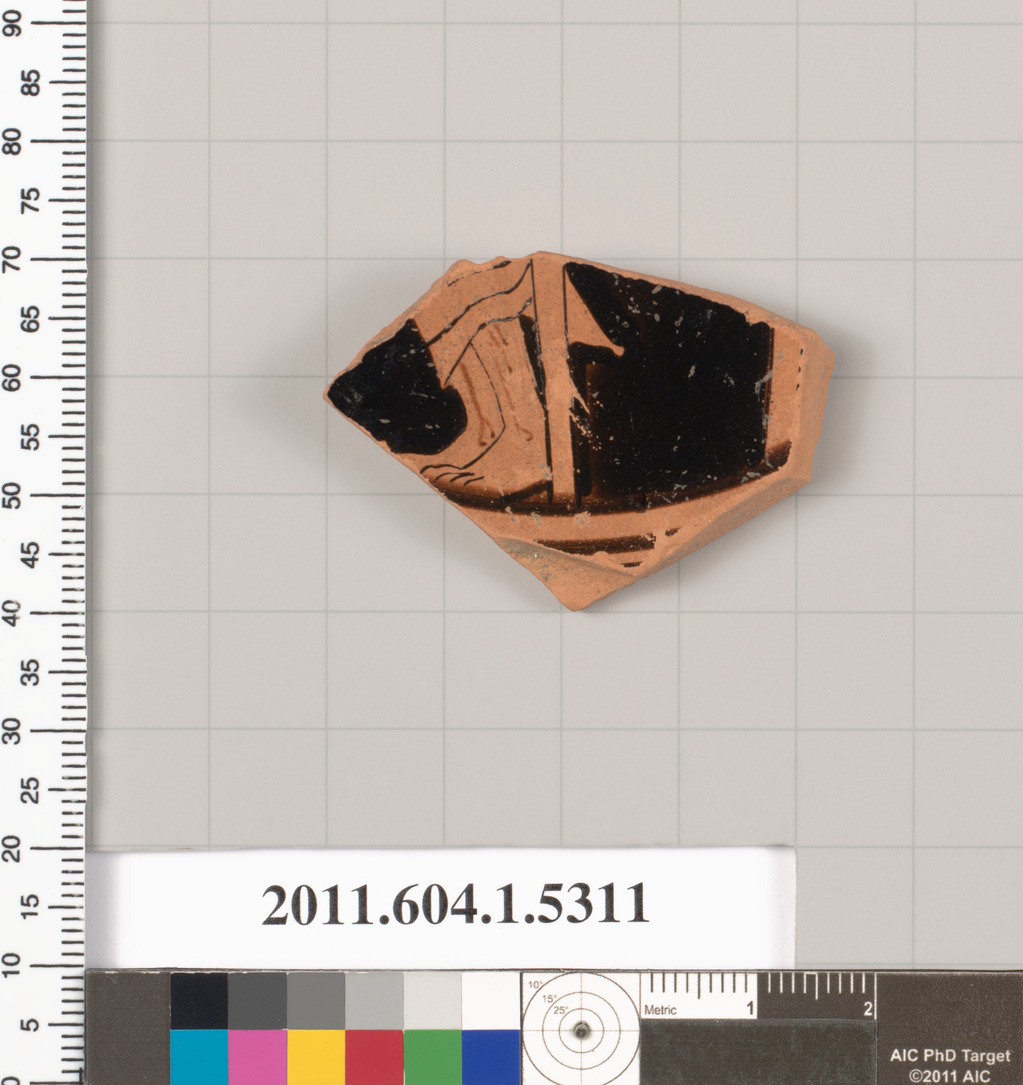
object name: kylix fragment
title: Terracotta fragment of a kylix (drinking cup)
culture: greek, attic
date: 500-470 BCE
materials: terracotta